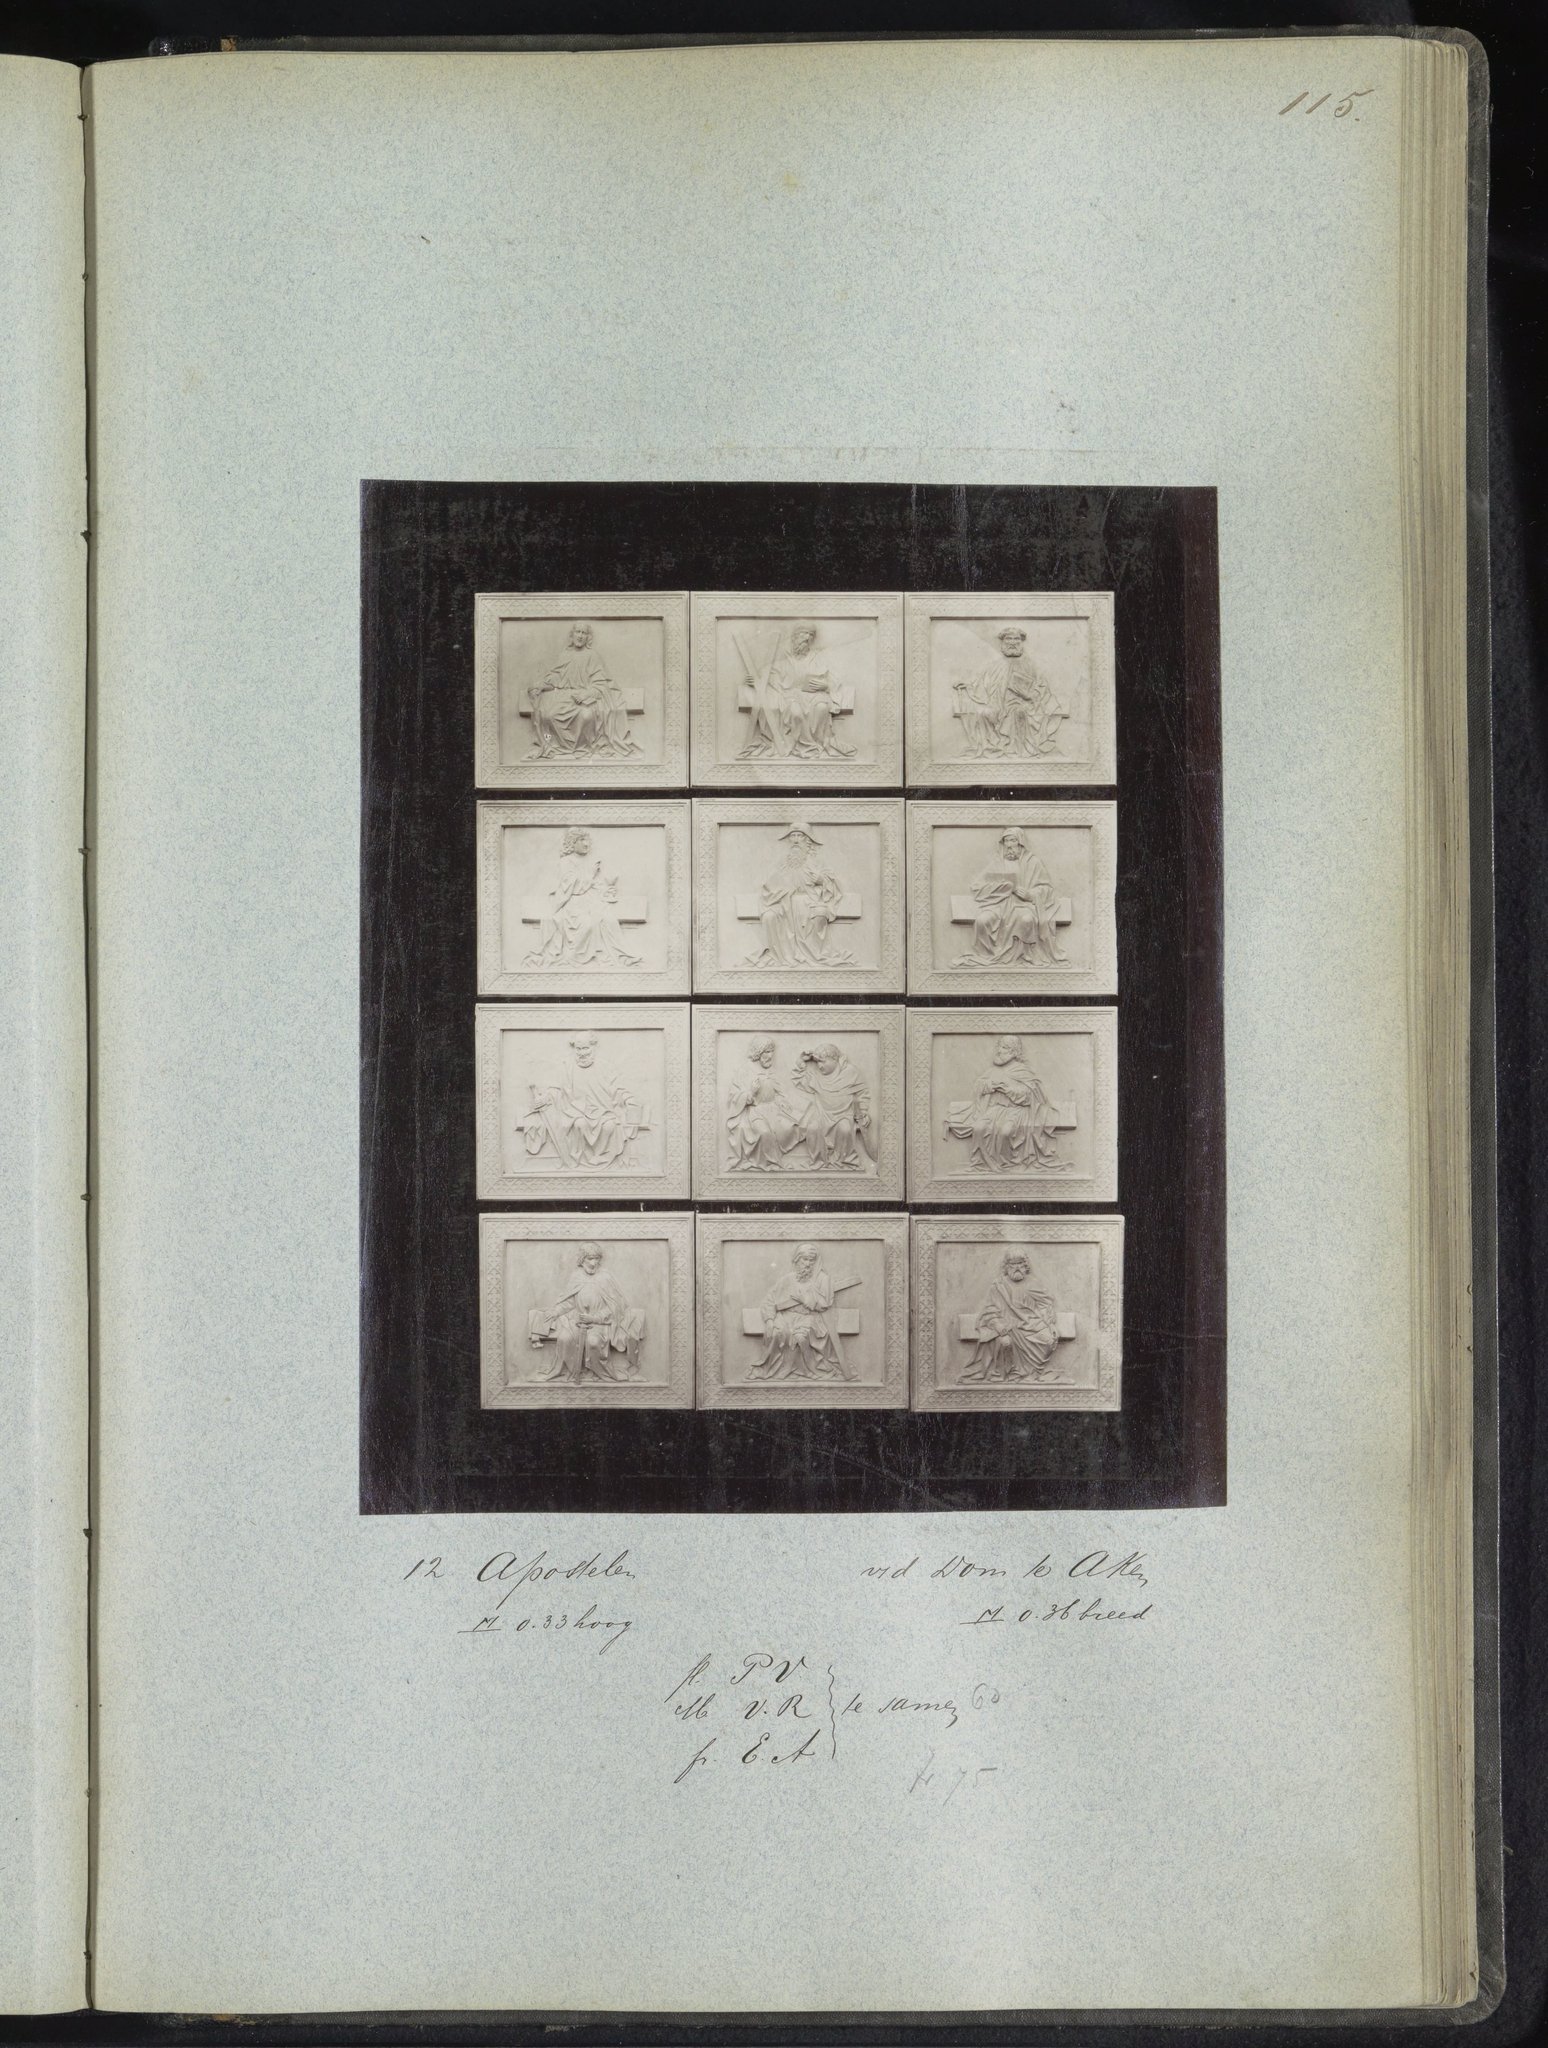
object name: photograph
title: Twaalf gipsen afgietsels van panelen van de twaalf apostelen uit de Dom van Aken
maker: Anonymous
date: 1875-1900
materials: paper, photographic support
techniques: albumen print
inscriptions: annotation: ‘12 Apostelen v/d Dom te Aken / M 0.33 hoog M 0.36 breed’, annotation